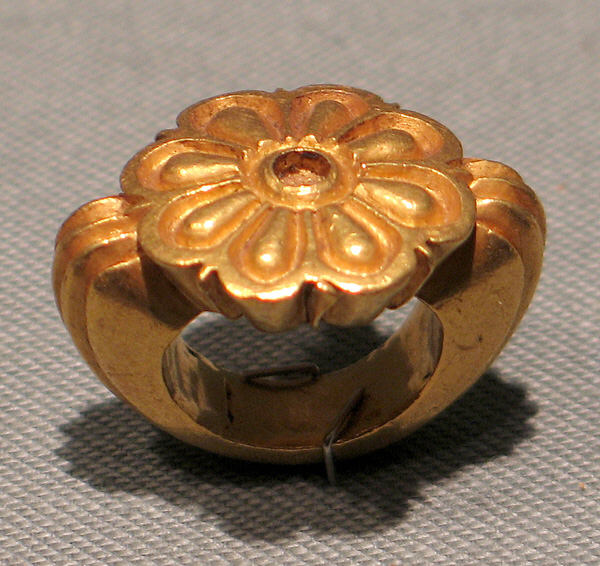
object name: ring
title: Stirrup-Shaped Ring with Open Lotus Design on Bezel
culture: indonesian, javanese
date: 701-933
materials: gold